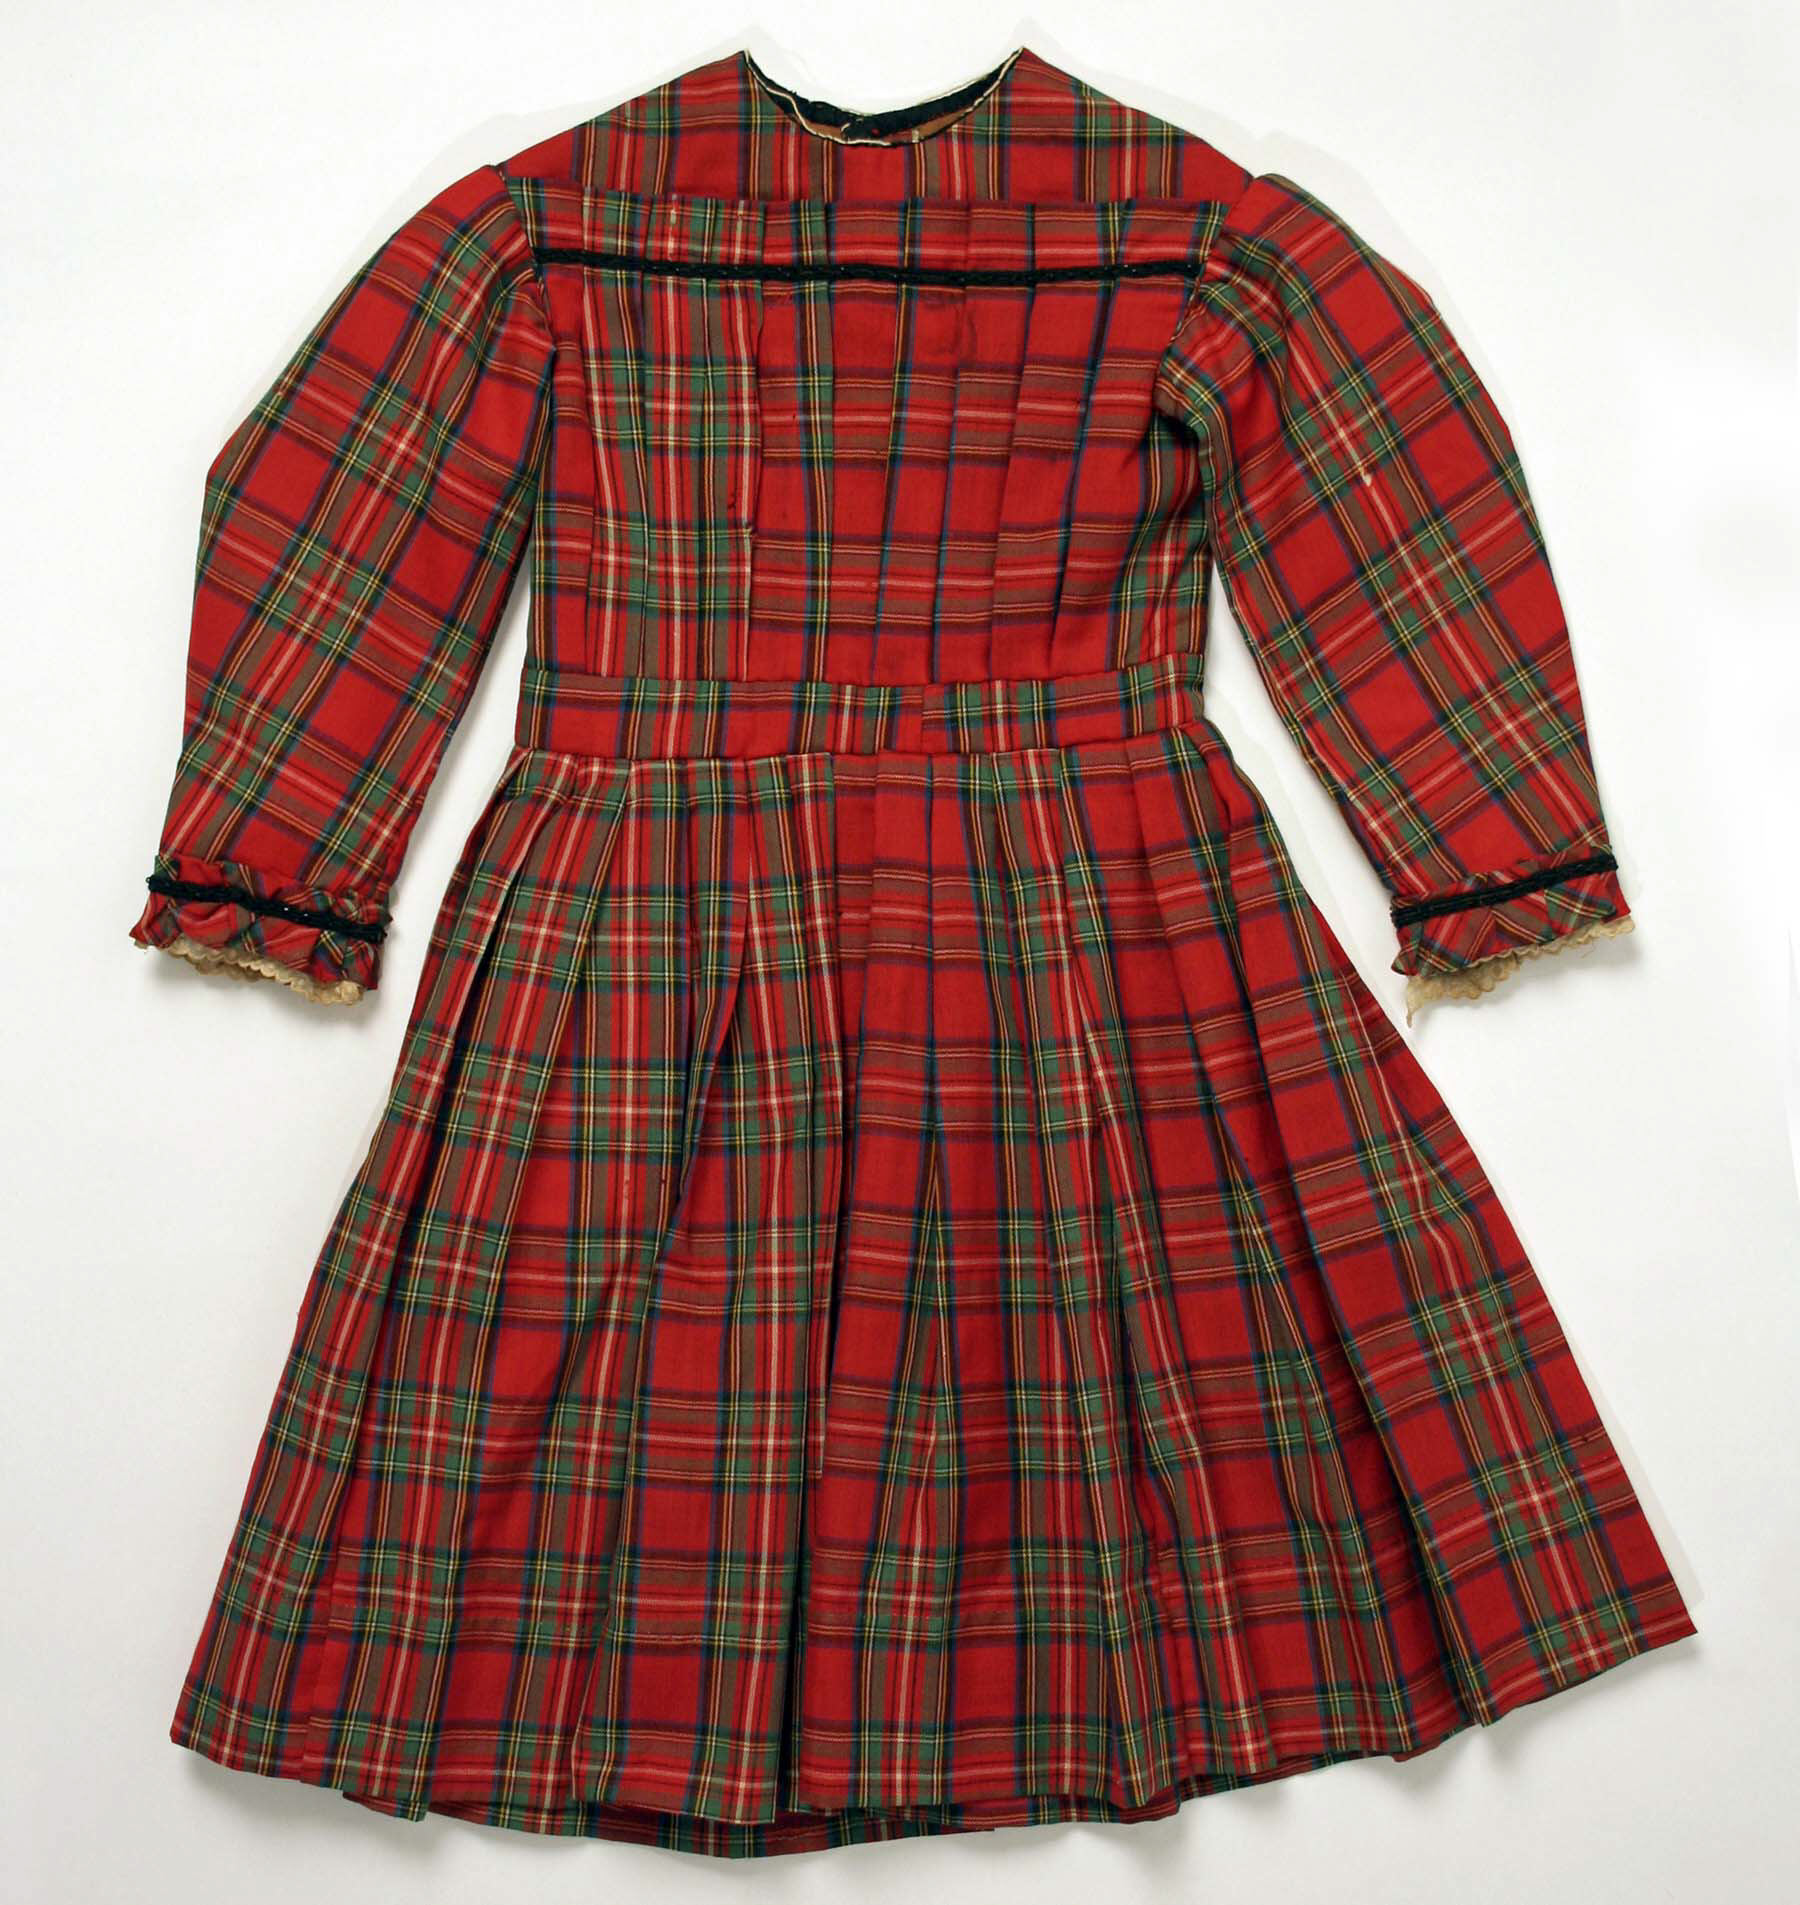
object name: dress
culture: american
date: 1870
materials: wool